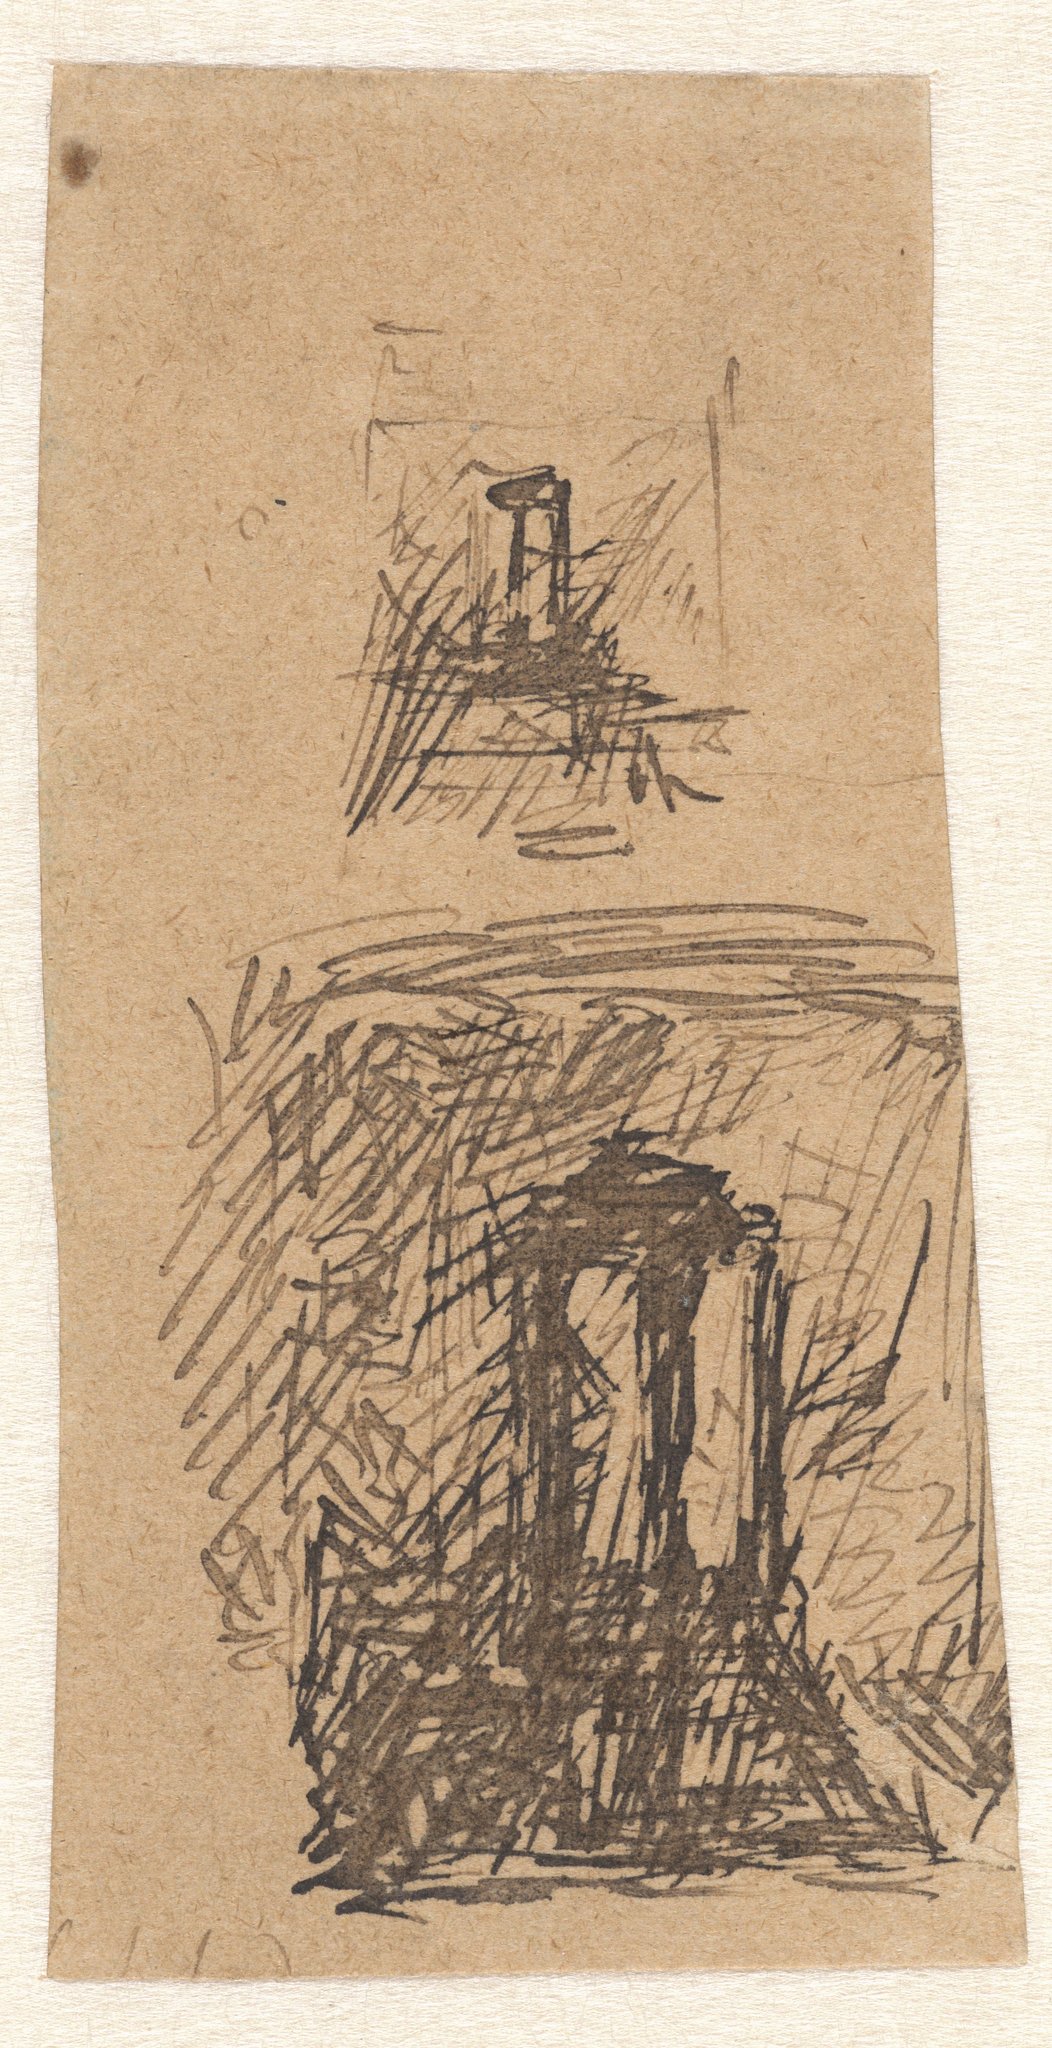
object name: drawing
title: Twee schetsen van enkele zuilen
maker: thomas cool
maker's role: draughtsman, painter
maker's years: 1851-1904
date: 1861-1904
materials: ink, paper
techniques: pen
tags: ruin of a building ~ architecture, landscape with ruins, rome